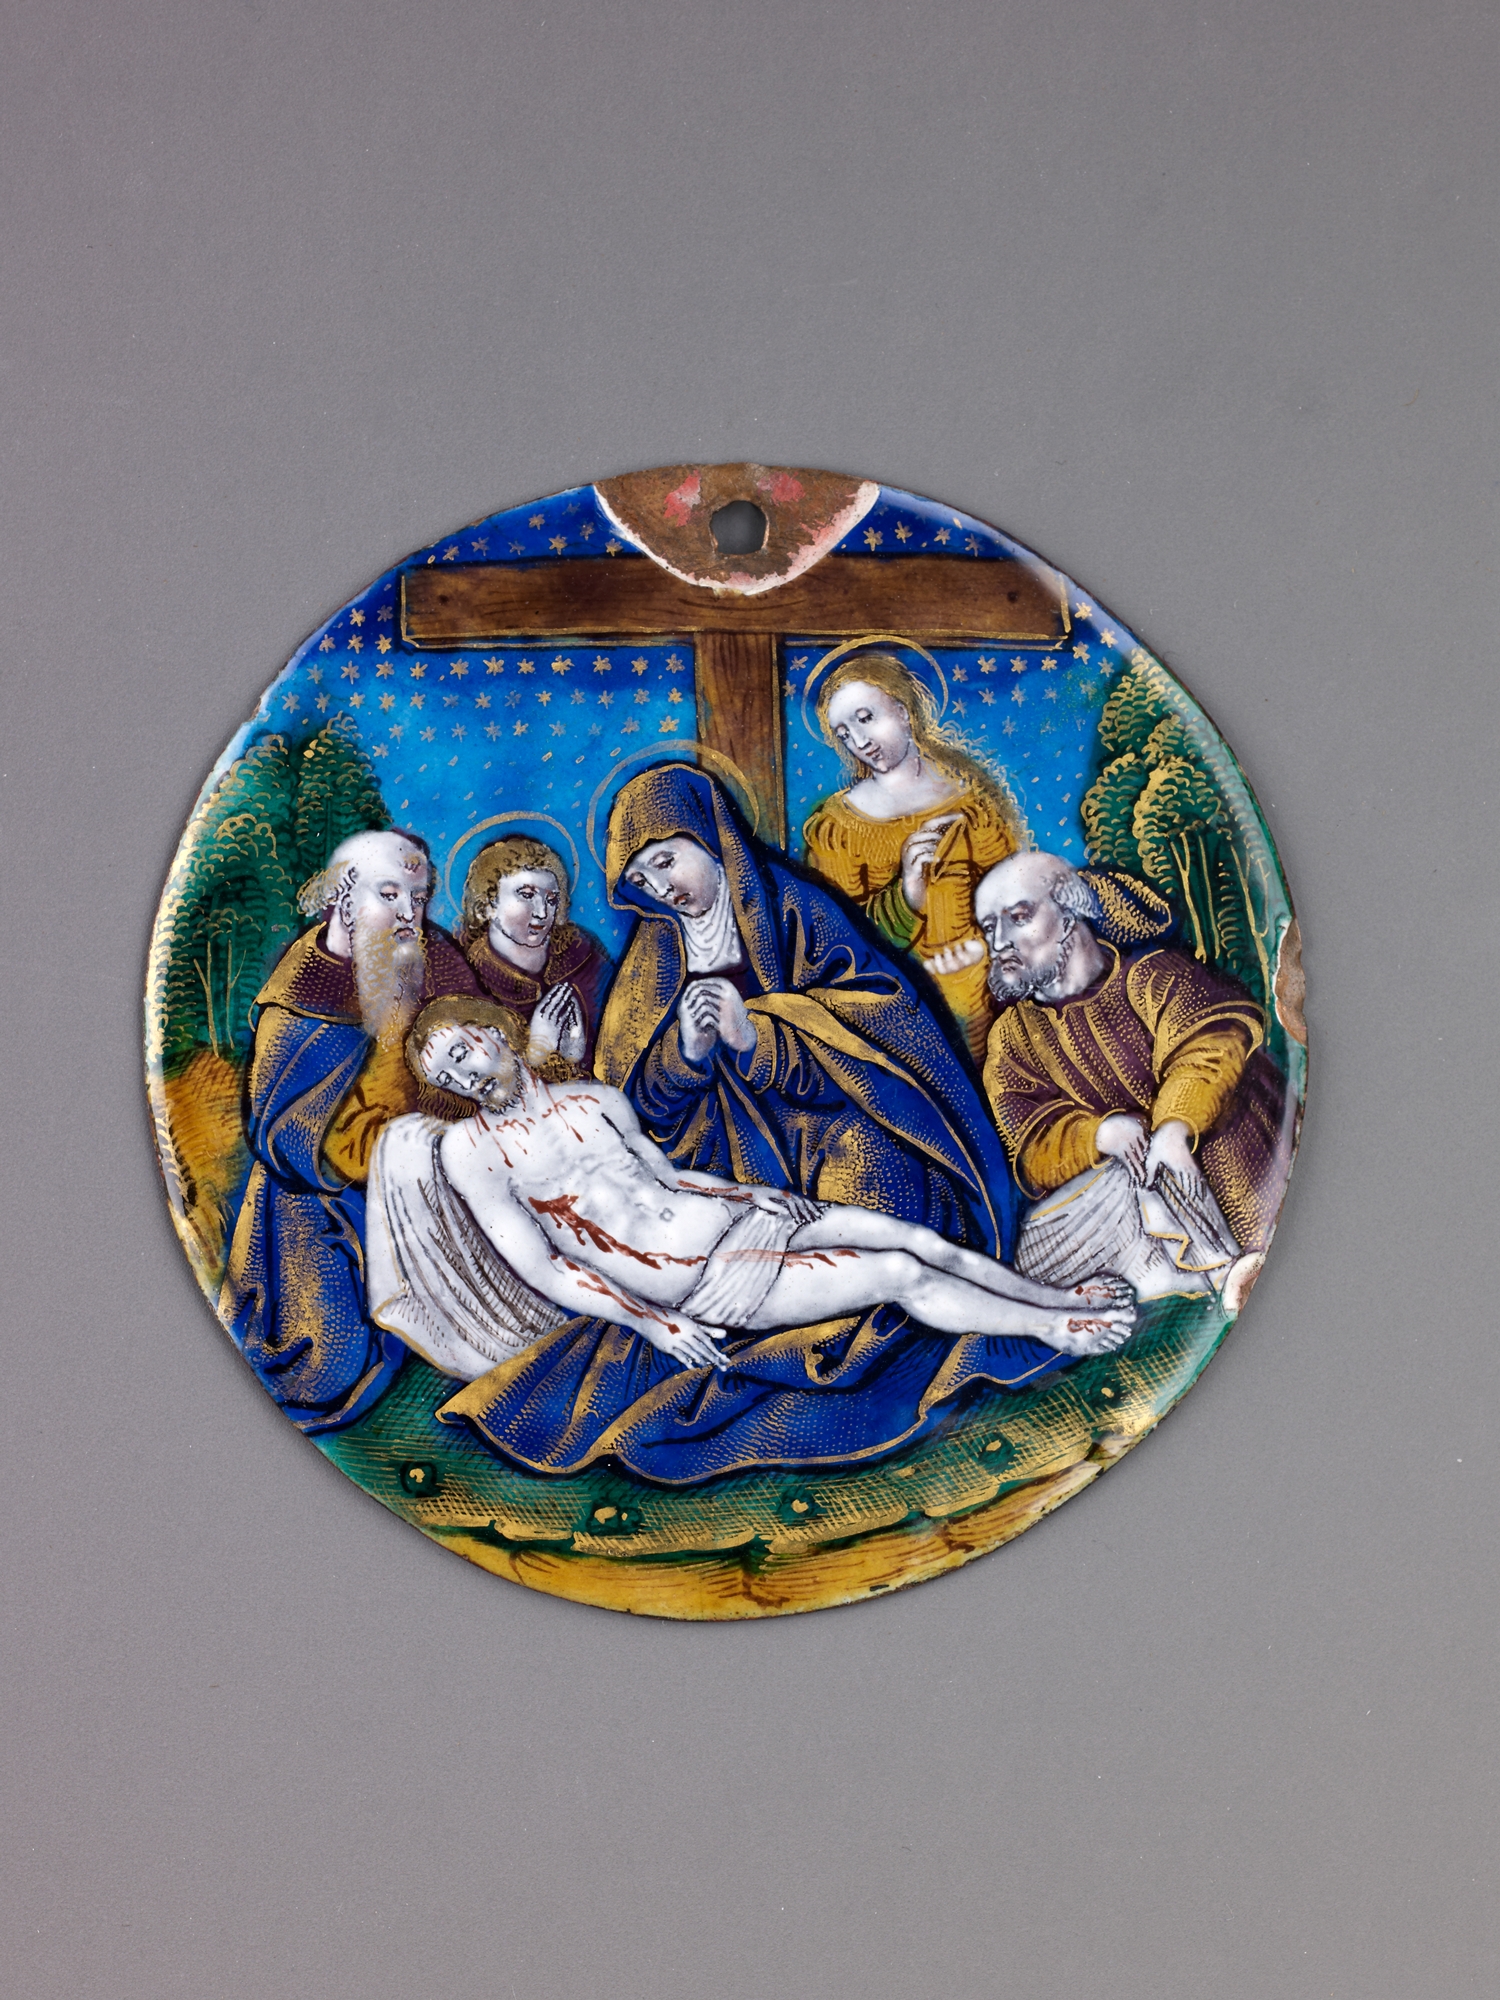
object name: medallion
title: Lamentation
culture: french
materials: copper, enamel, gilt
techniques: painting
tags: christ,virgin mary,lamentation,saints